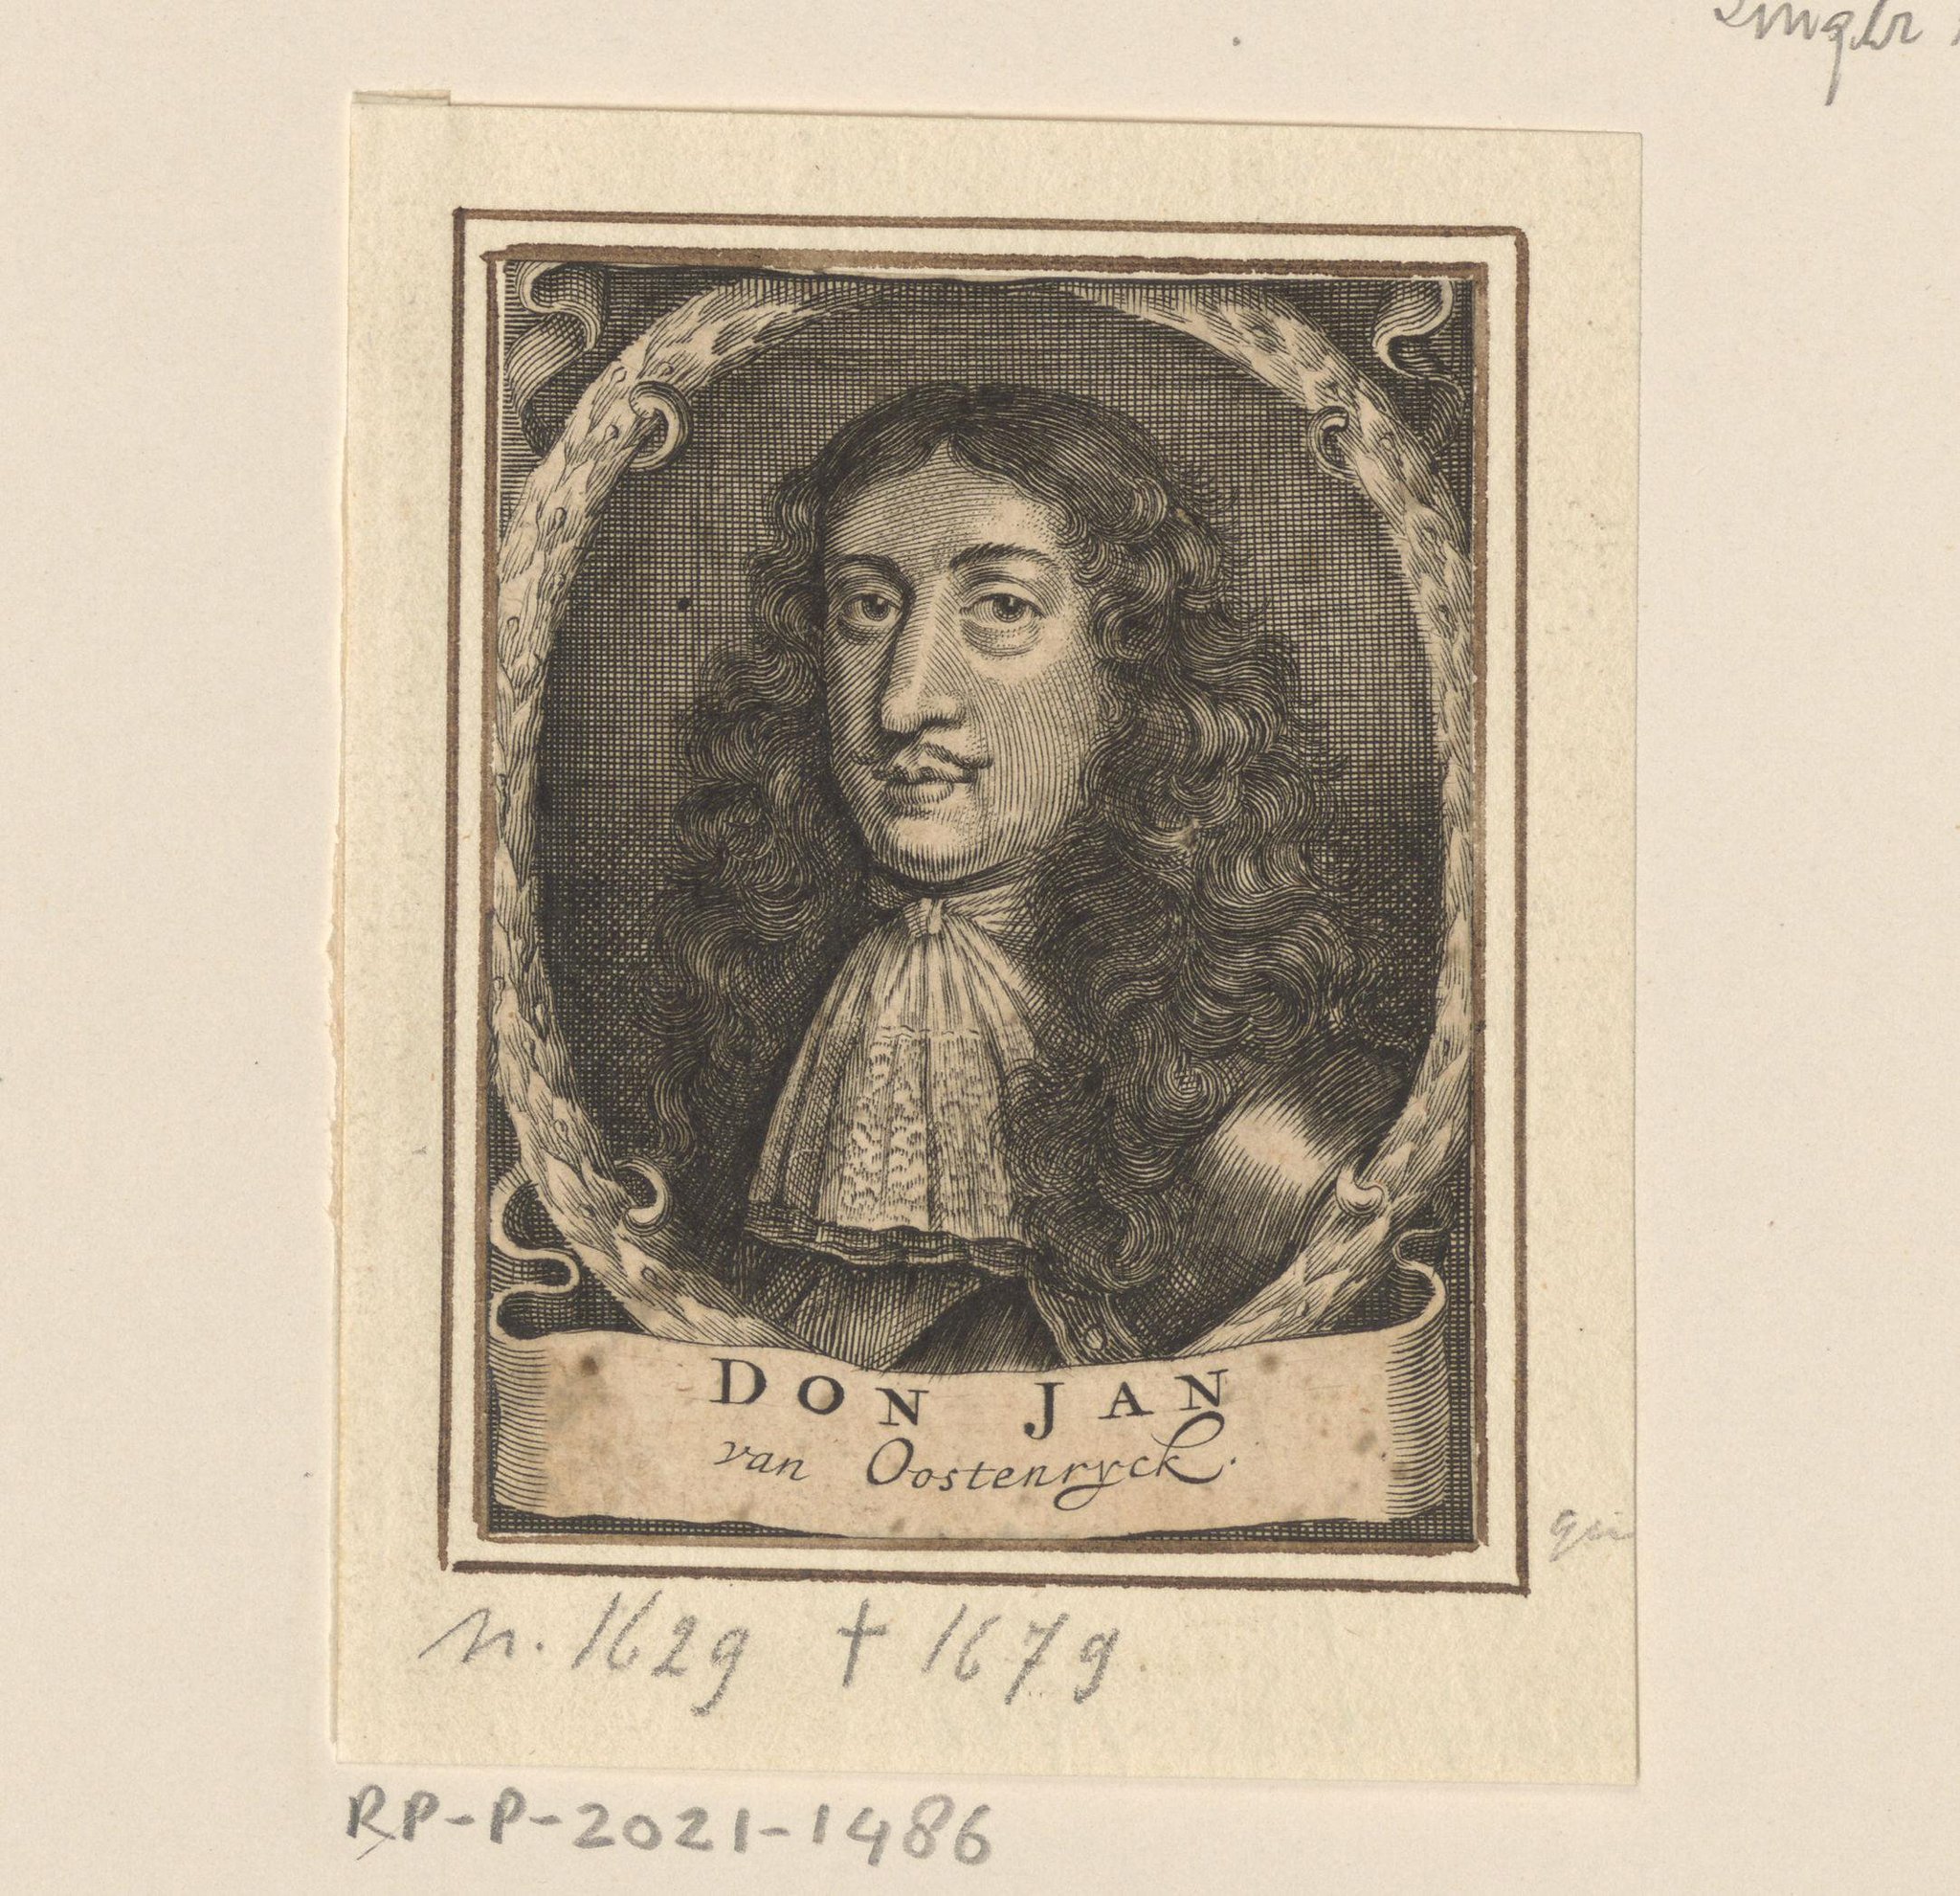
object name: print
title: Portret van Don Juan II van Oostenrijk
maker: Anonymous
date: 1650-1749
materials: paper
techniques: engraving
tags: historical persons, ruler, sovereign, armorial bearing, heraldry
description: Prent mogelijk uit: Brandt, Geeraert II. Tweejaerige geschiedenissen, voorgevallen in de jaeren MDCLXXIV. Amsterdam: Johannes van Someren, Abraham Wolfgangh, Hendrik en Dirk Boom, 1678.